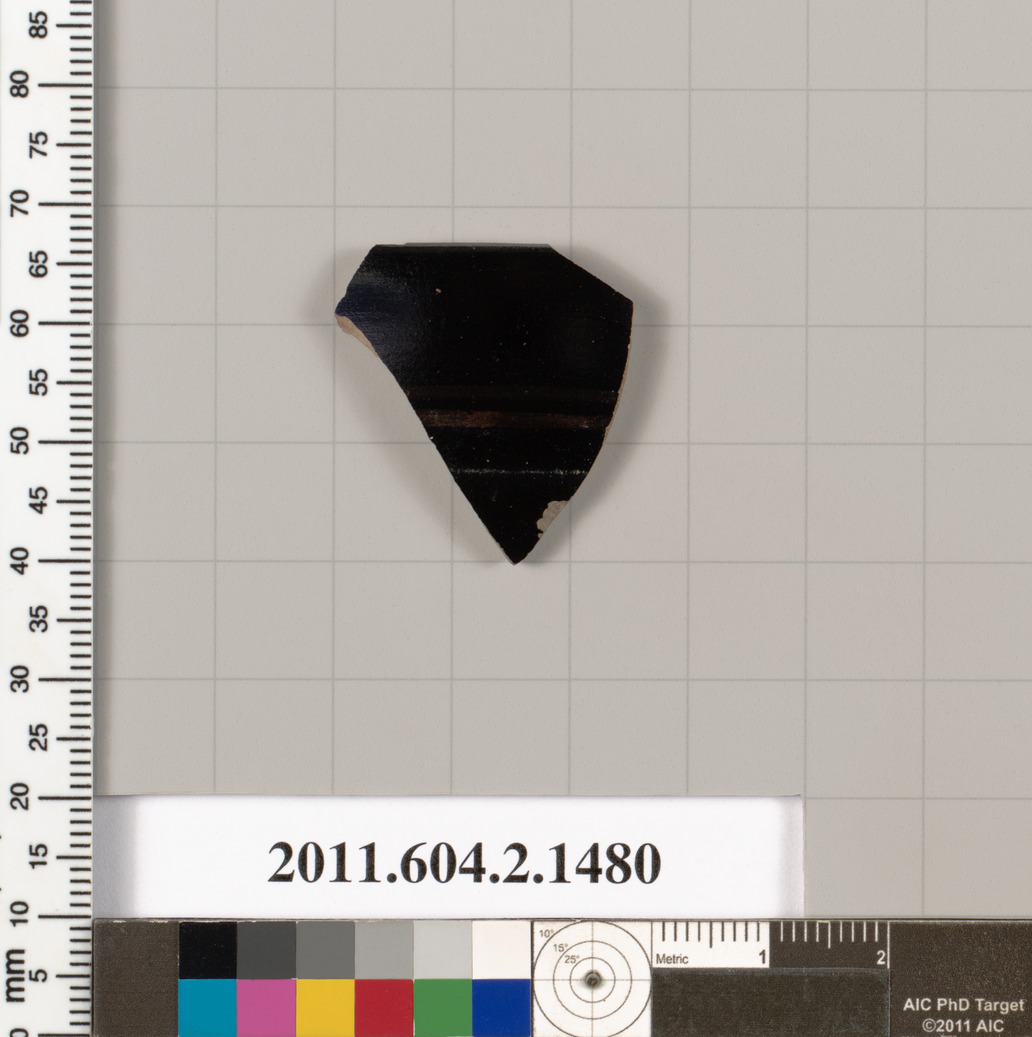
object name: skyphos fragment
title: Terracotta rim fragment of a skyphos (deep drinking cup)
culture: greek, attic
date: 600-401 BCE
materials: terracotta